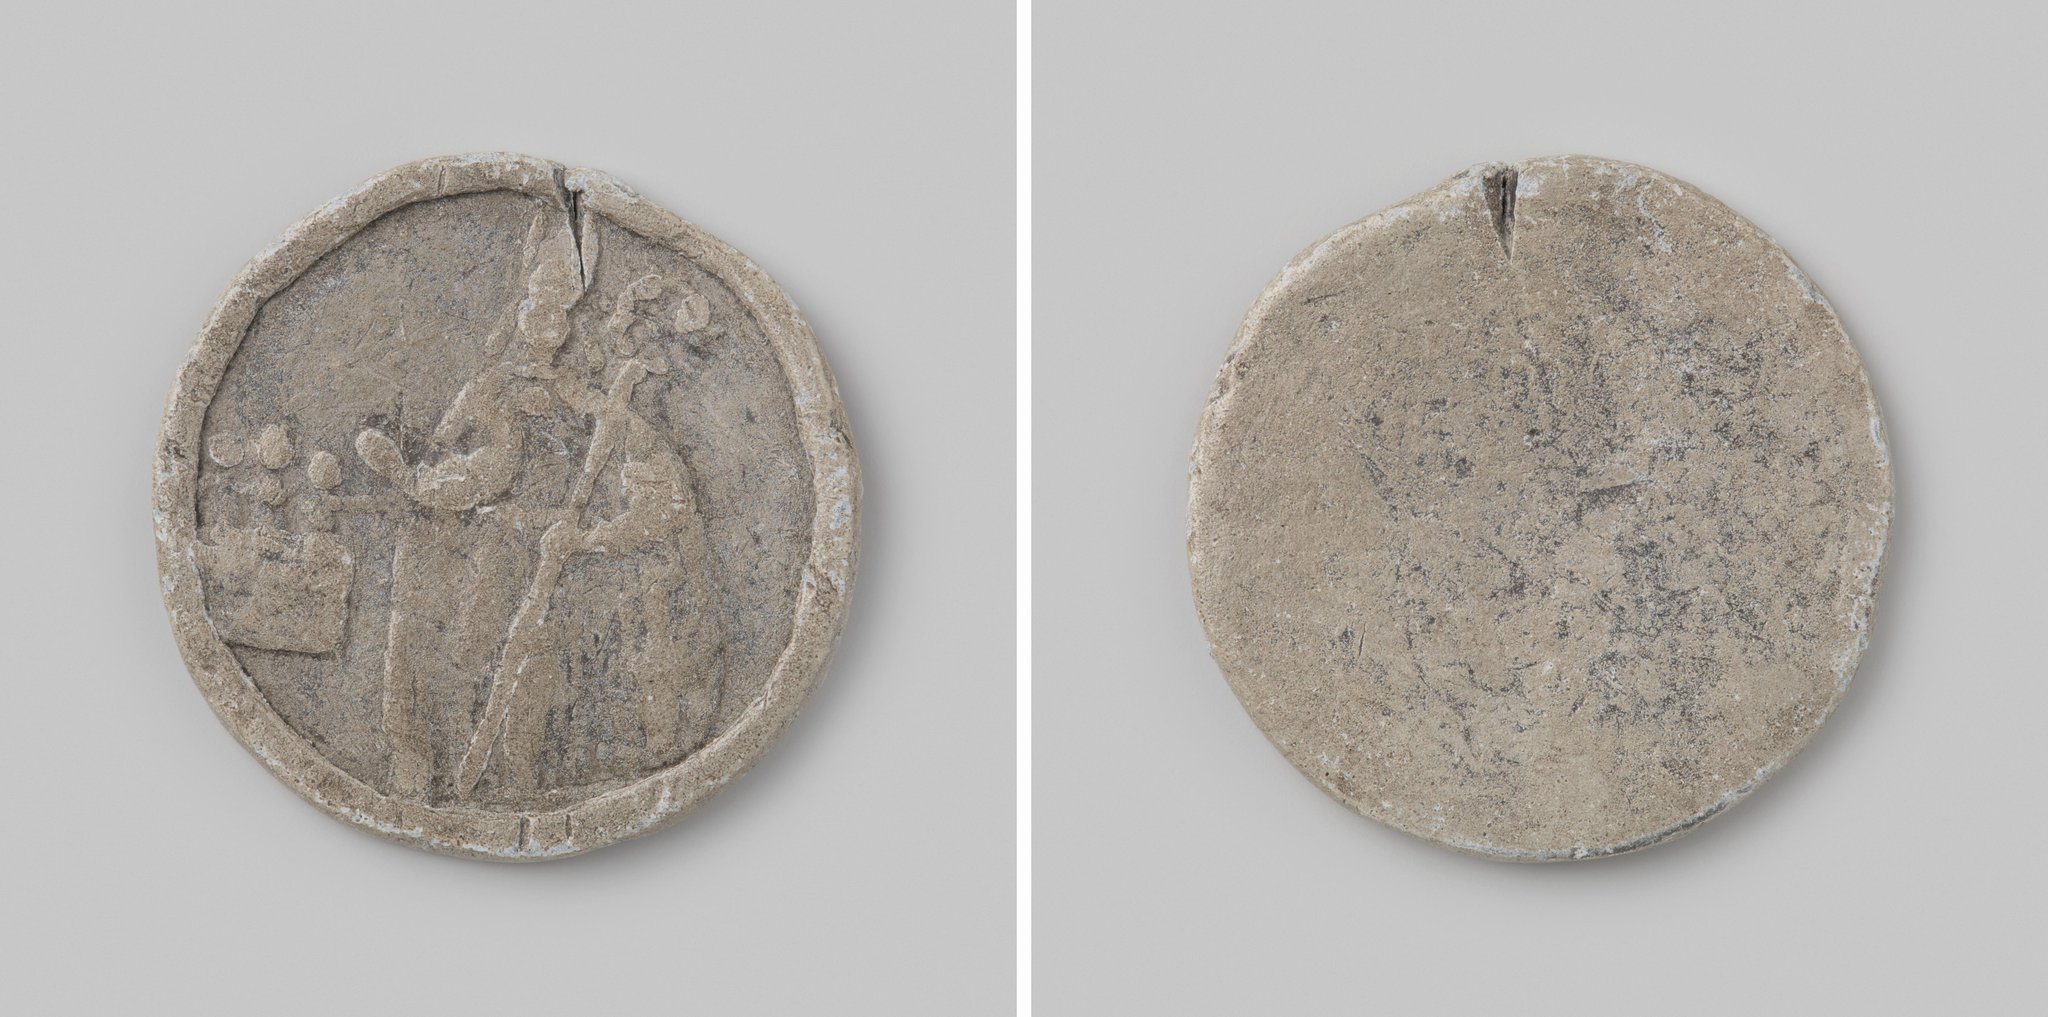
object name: history medal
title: Presentiepenning van het Kramersgilde te Maastricht 1736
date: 1736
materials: brass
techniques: casting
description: Gegoten loden penning met Sint Nicolaas en drie kinderen in een kuip, de keerzijde lijkt blanco